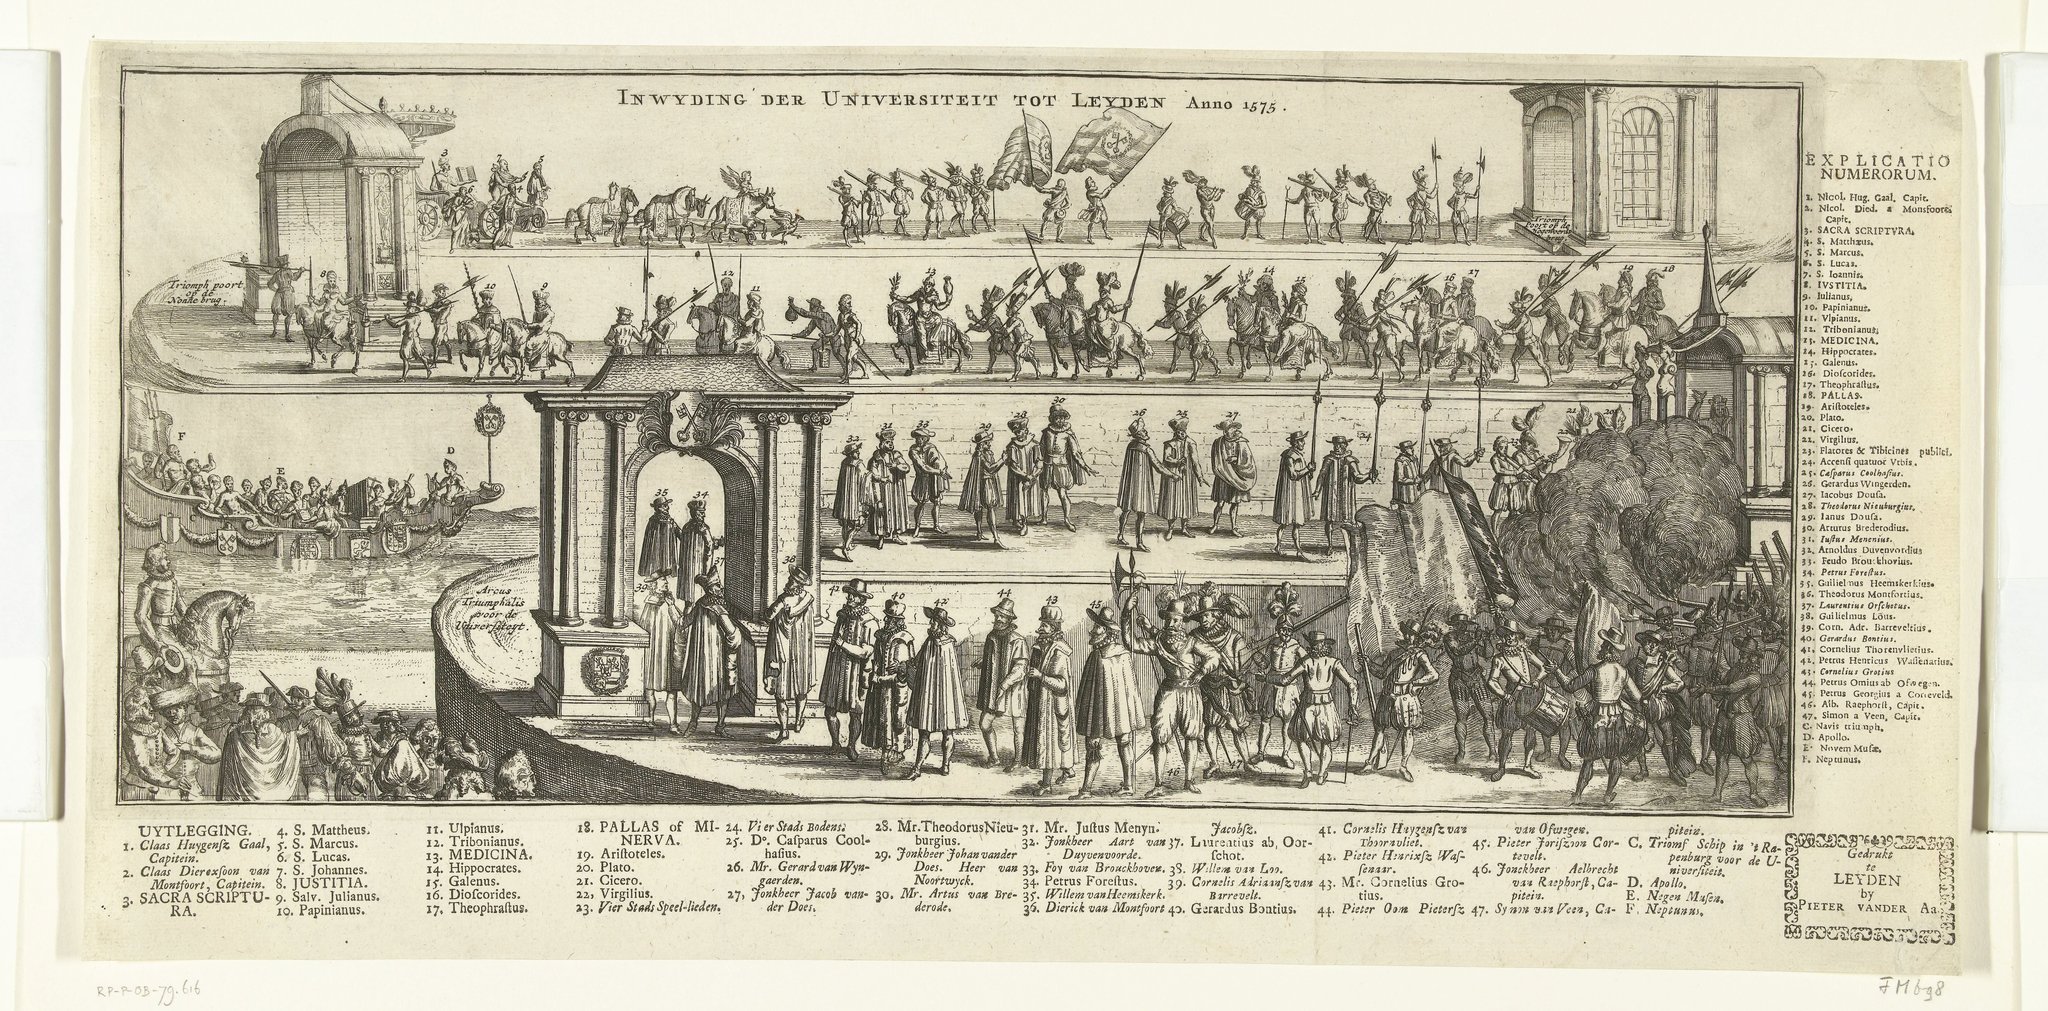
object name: print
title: Optocht bij de inwijding van Universiteit van Leiden, 1575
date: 1779-1781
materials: paper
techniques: etching, letterpress printing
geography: leiden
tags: festivities (+ parade, pageant, cavalcade ~ festive activities), founding of a university, leiden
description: Optocht bij de inwijding van Universiteit van Leiden, 8 februari 1575. Stoet in drie rijen boven elkaar afgebeeld. Rechtsonder soldaten, muzikanten, vaandeldragers en vreugdeschoten. Links lopen hoogwaardigheidsbekleders en professoren door een triomfpoort met het wapen van Leiden. Linksonder het schip met Neptunus, Apollo en de negen muzen. Elementen in de voorstelling aangeduid met cijfers en letters. Onderaan de legenda in het Nederlands, rechts de legenda in het Latijn.